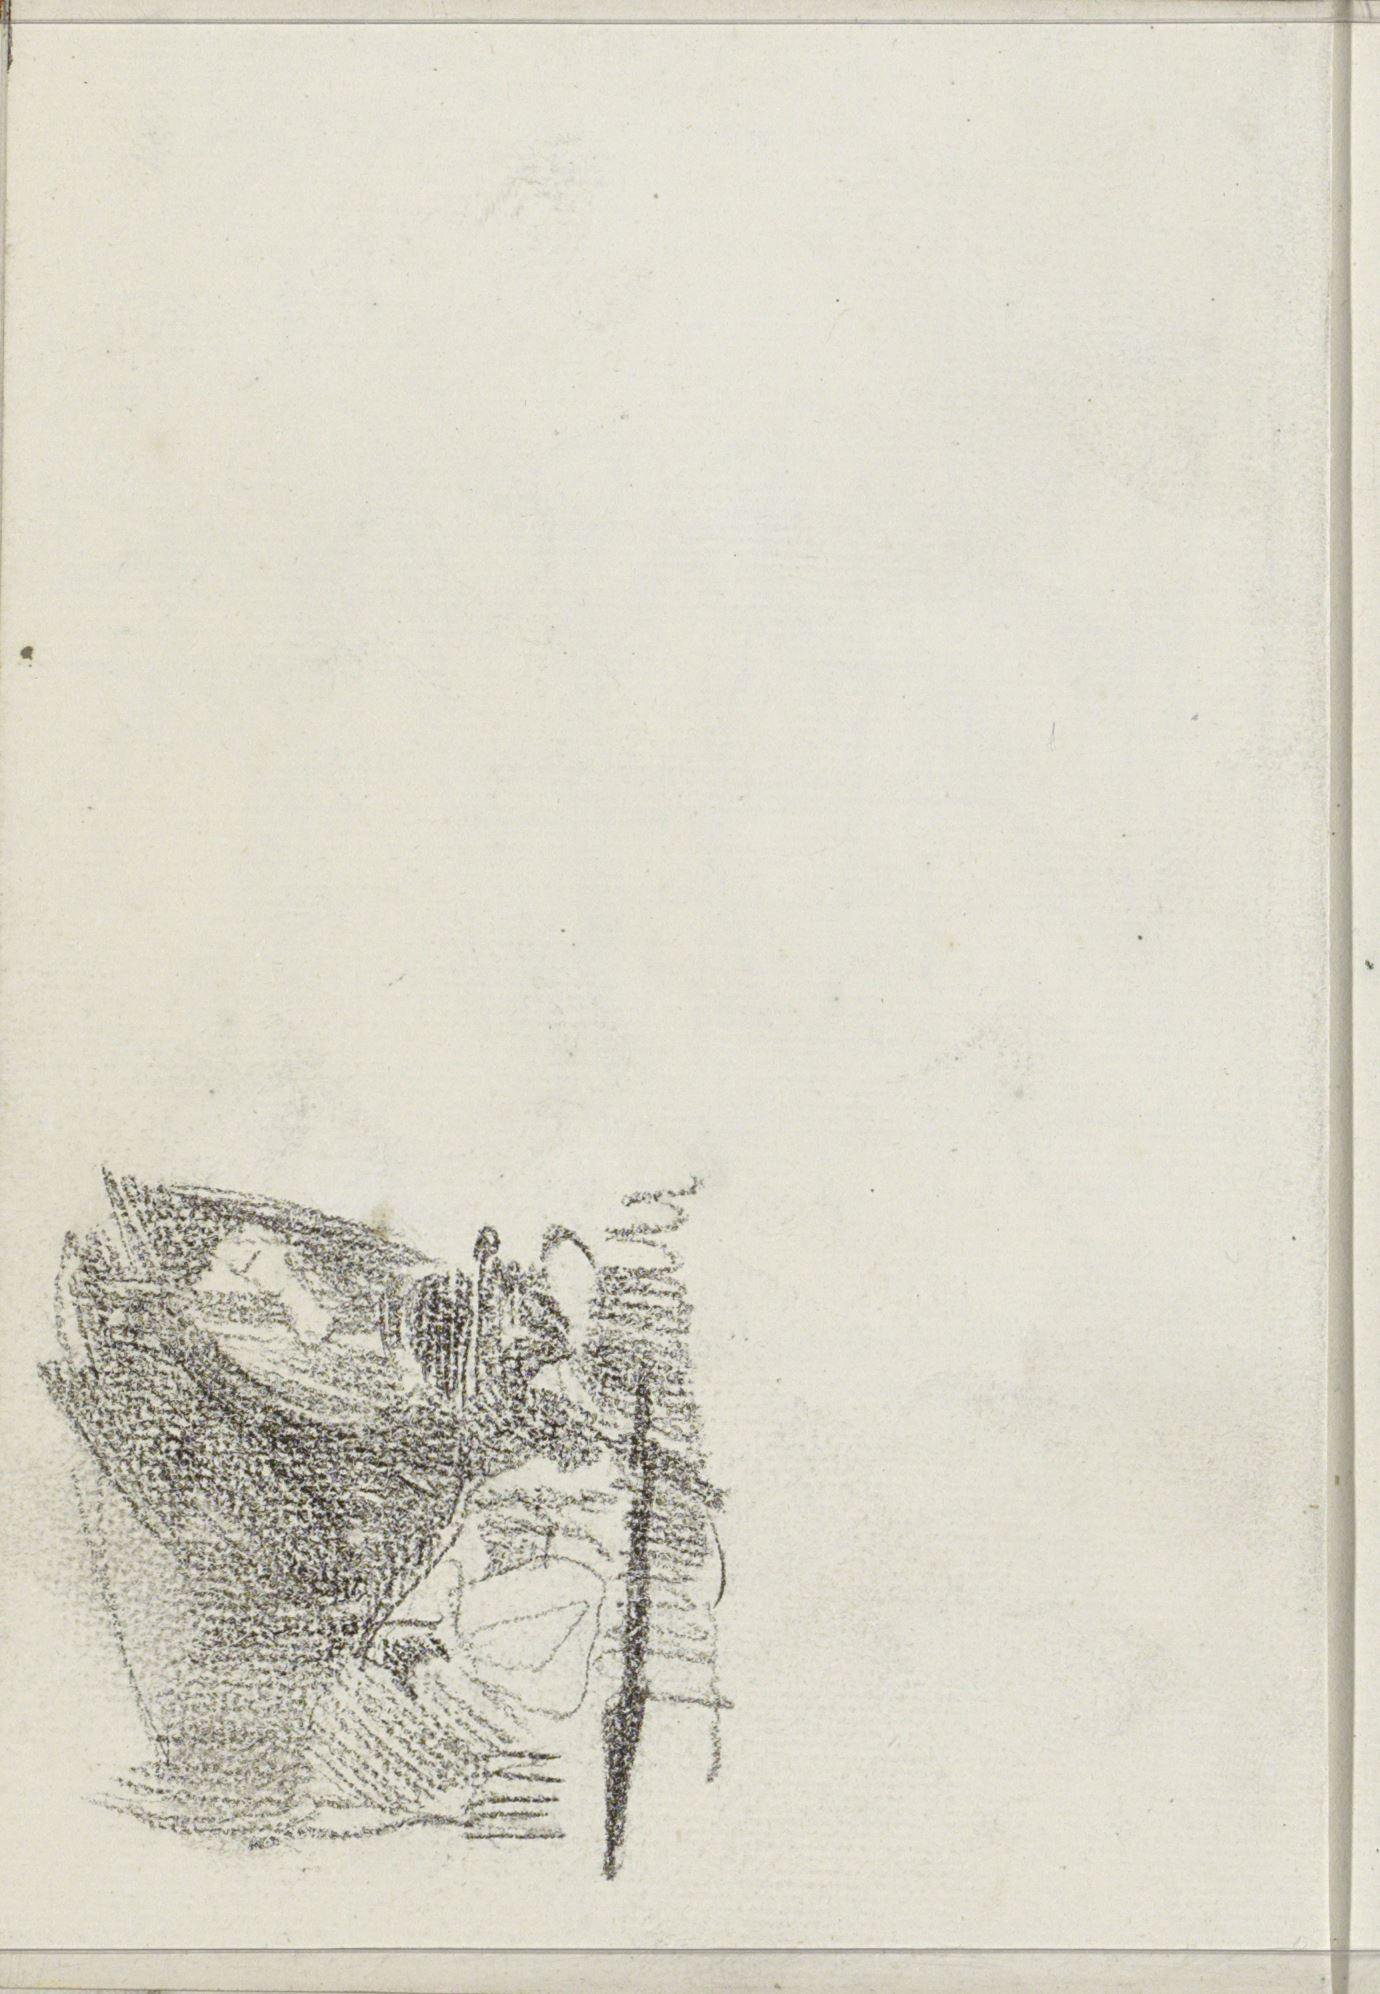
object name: sketchbook leaf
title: Studie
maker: isaac israels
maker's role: draughtsman, painter, print maker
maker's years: 1865-1934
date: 1886-1903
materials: chalk, paper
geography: amsterdam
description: Pagina 20 uit schetsboek XXXVII met 52 pagina's.